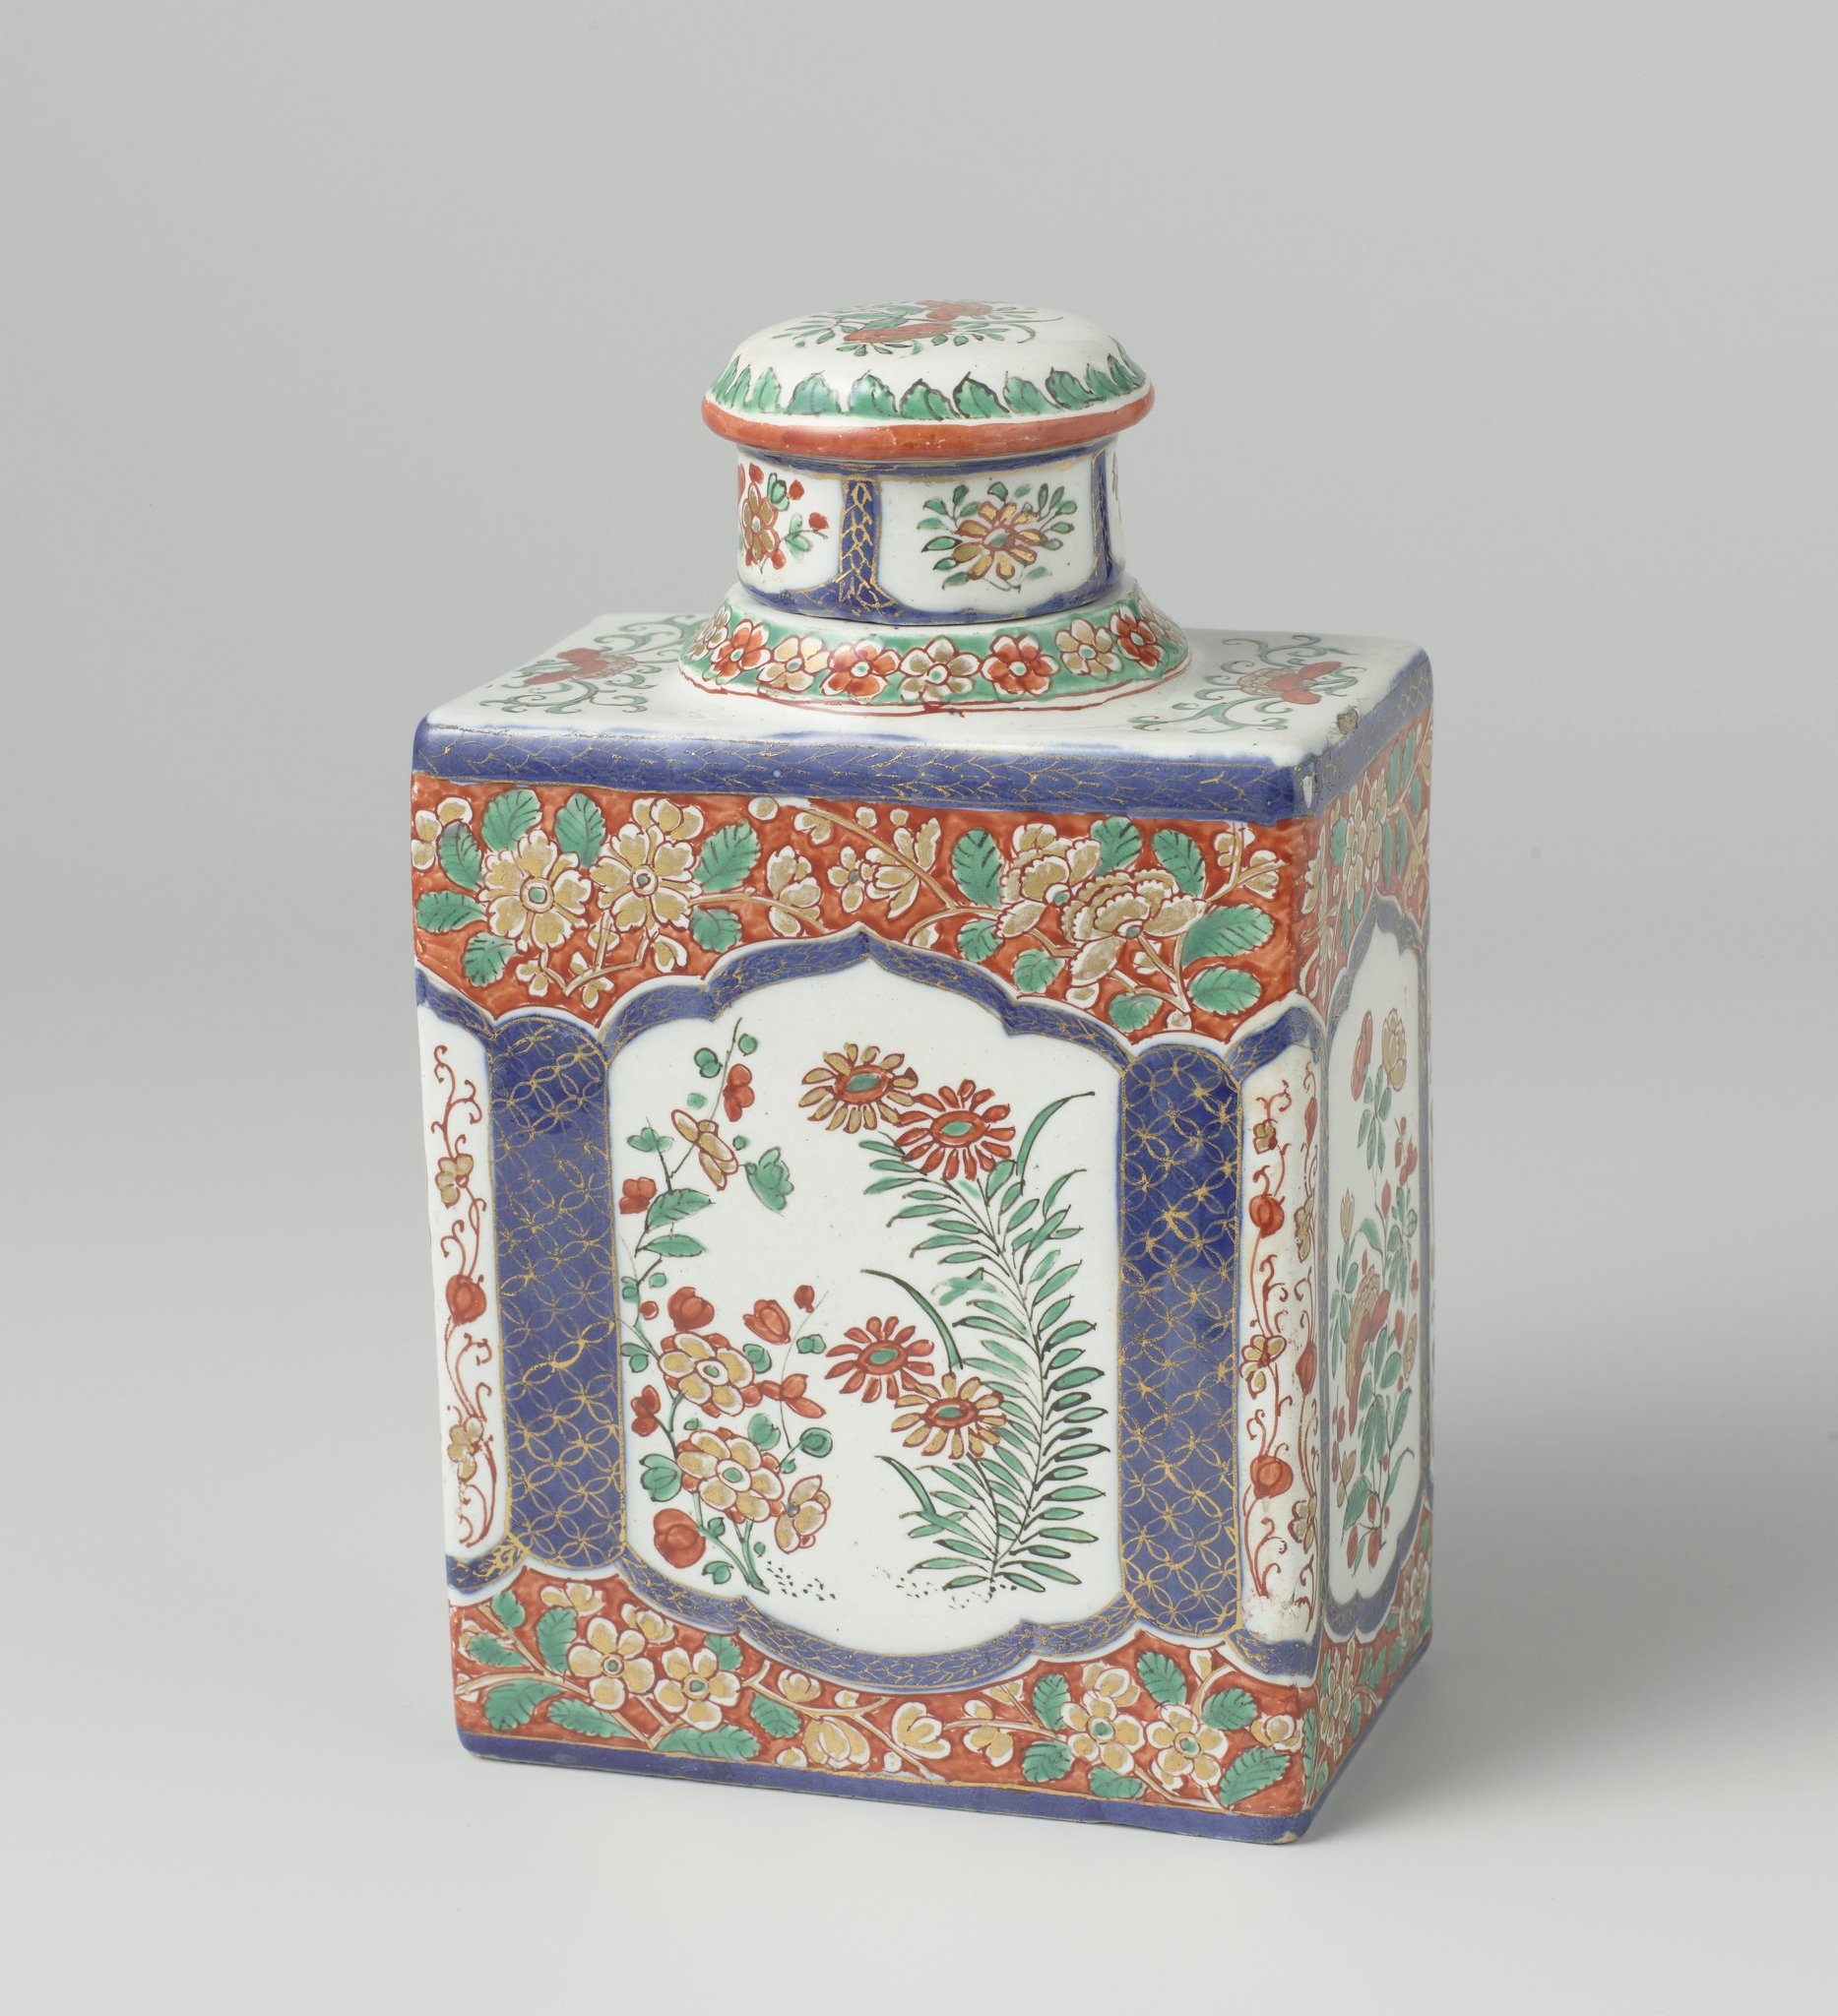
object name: tea caddy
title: Theebus van veelkleurig beschilderde faïence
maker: pieter adriaensz. kocx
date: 1710-1725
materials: earthenware, glaze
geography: delft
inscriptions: mark: ‘APK (ineen)’, collector's mark: ‘collection J.F. Loudon’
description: Theebus van faïence. Met deksel. Veelkleurig beschilderd met bloemendecoraties.